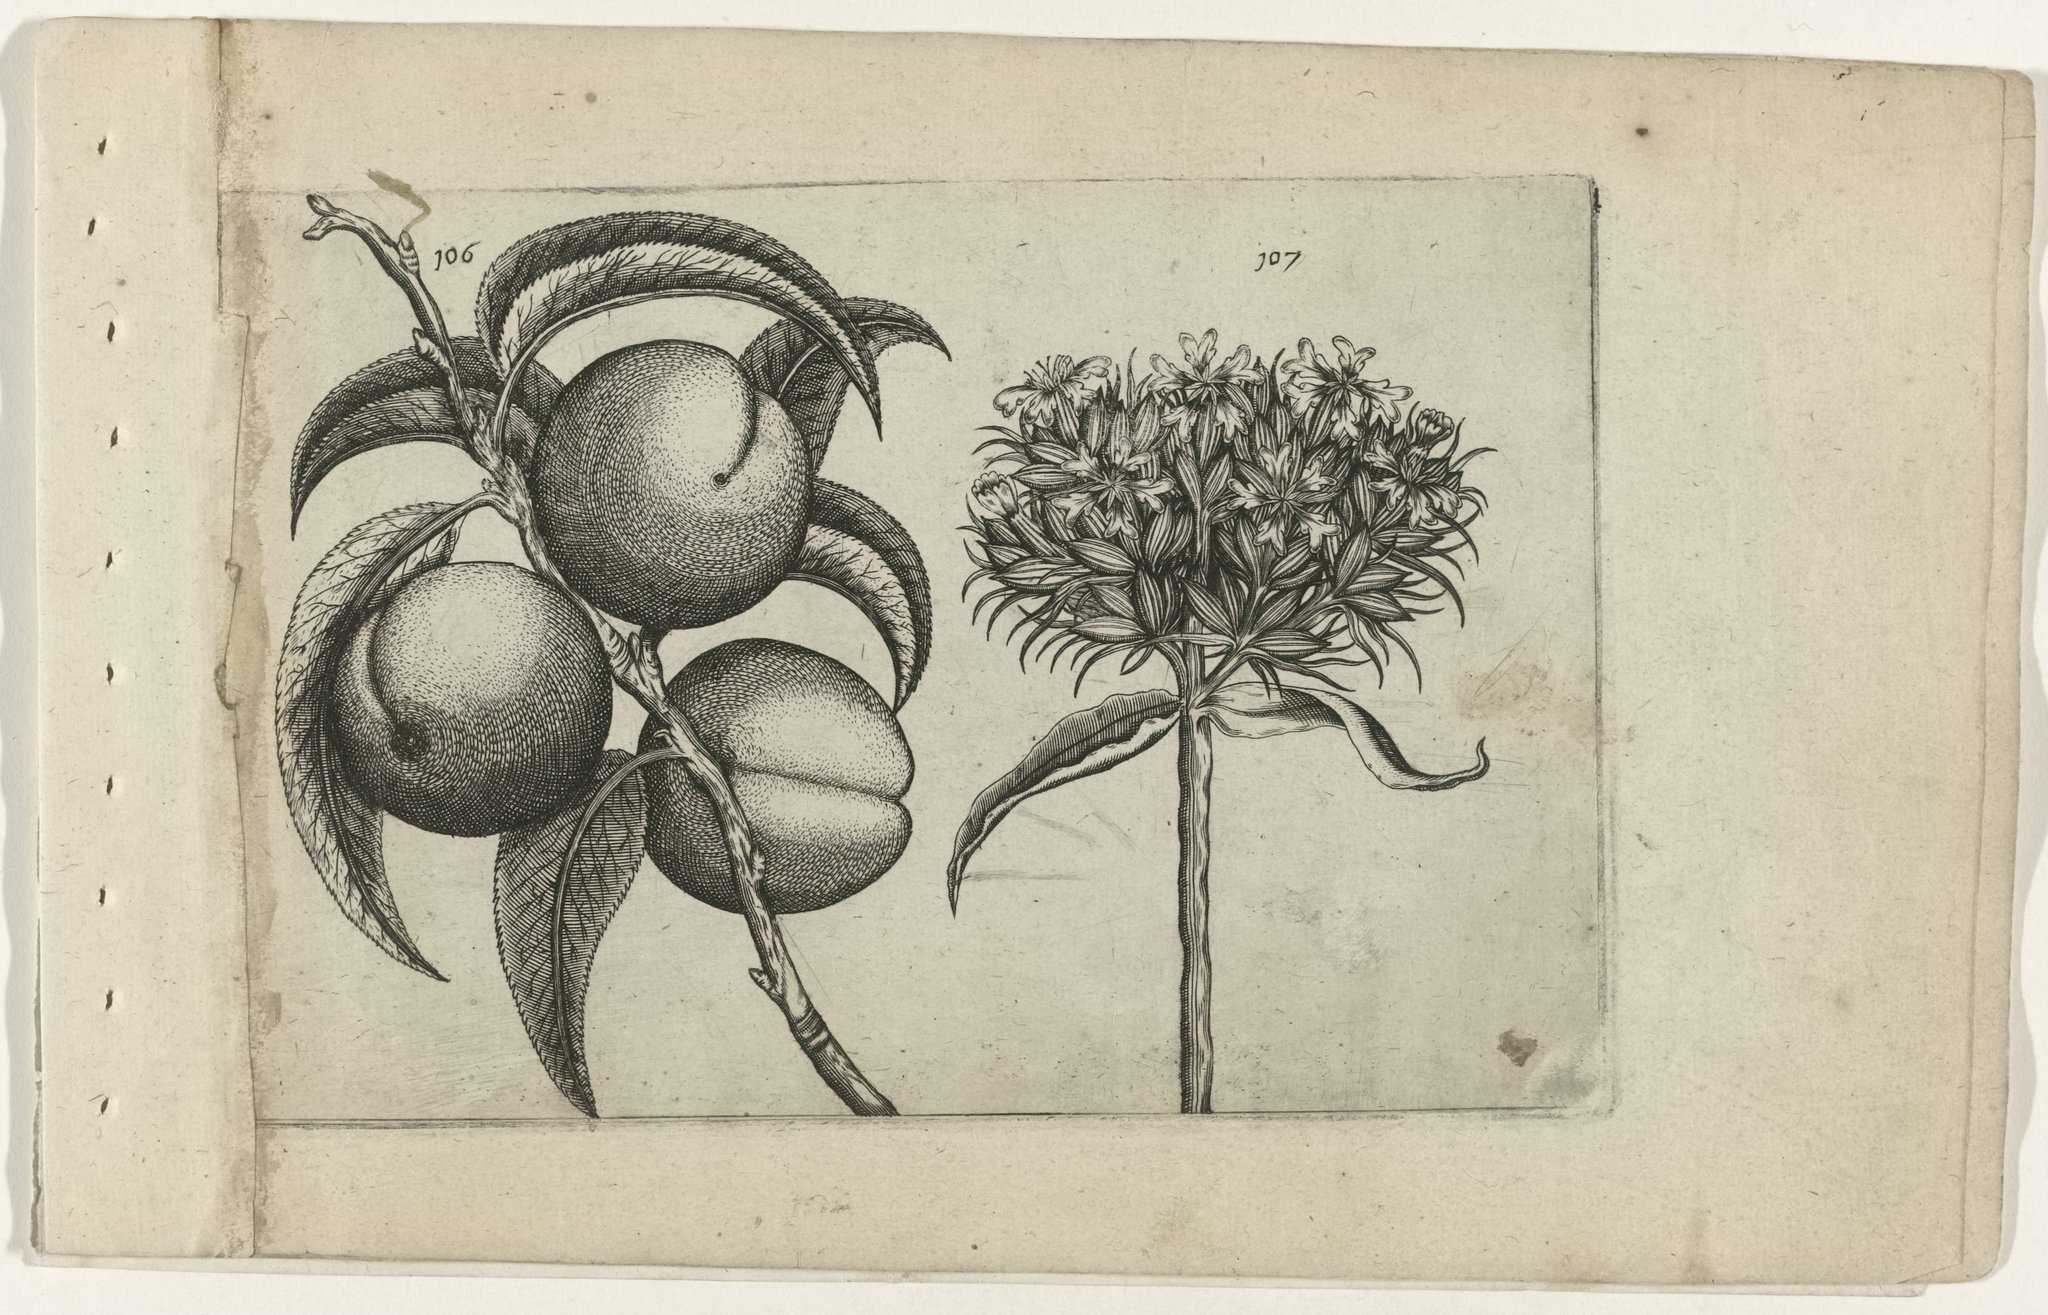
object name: album leaf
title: Perzik en brandende liefde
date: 1600-1604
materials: paper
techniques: engraving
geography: london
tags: flowers: burning love, fruits: peach, botany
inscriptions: collector's mark: Lugt 2228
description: De prenten RP-P-2012-24-1 t/m 61 waren oorspronkelijk als serie samengebonden. De naaigaten op de bladen zijn nog zichtbaar. Het betreft de reeks getiteld: Cognoscite lilia, bestaande uit een titelprent en 60 gravures met 119 genummerde weergaven van planten, bloemen en vruchten, versierd met rinceaux en kleine voorstellingen van dieren. Het gaat om proefdrukken van deze reeks gravures, voor de opschriften en, deels, voor de nummering. Op enkele prenten zijn de nummers met de hand aangebracht. Op de titelprent ontbreekt nog het adres van Crispijn de Passe en Hans Woutneel. De titel is hoogstwaarschijnlijk gegraveerd door Matthias Quad. Deze werkte voor De Passe in Keulen tot 1604. De reeks moet in dit jaar of daarvoor tot stand zijn gebracht. In ieder geval voor 1608, aangezien de uitgever Hans Woutneel in of voor dat jaar overleed. In ieder geval voor 1608, aangezien de uitgever Hans Woutneel in of voor dat jaar overleed. De gravures worden door Ilja Veldman en Anthony Griffiths beschouwd als eigenhandig werk van Crispijn de Passe I. Een van de prenten uit de reeks ontbreekt (nr 21-22) en is vervangen door een ingekleurde afdruk uit een latere uitgave (RP-P-2012-24-61), die onder de titel Altera Pars is opgenomen in de Hortus Floridus, uitgegeven door Crispijn de Passe I en die verder bestaat uit platen van Crispijn de Passe II. De prenten afkomstig uit deze uitgave zijn op de verso voorzien van tekst in boekdruk. De vervangende prent maakte geen deel uit van de gebonden serie aangezien dit blad als enige geen naaigaten heeft. Een deel van de planten, bloemen en vruchten in de Cognoscite lilia gaat terug of is gebaseerd op een reeks aquarellen van Jacques LeMoyne uit circa 1580 en uit 1585, nu in het Victoria and Albert Museum en de British Museum (zie P. Hulton, Jacques LeMoyne, Londen 1977, dl 1, p. 156-162 en p. 165-173).